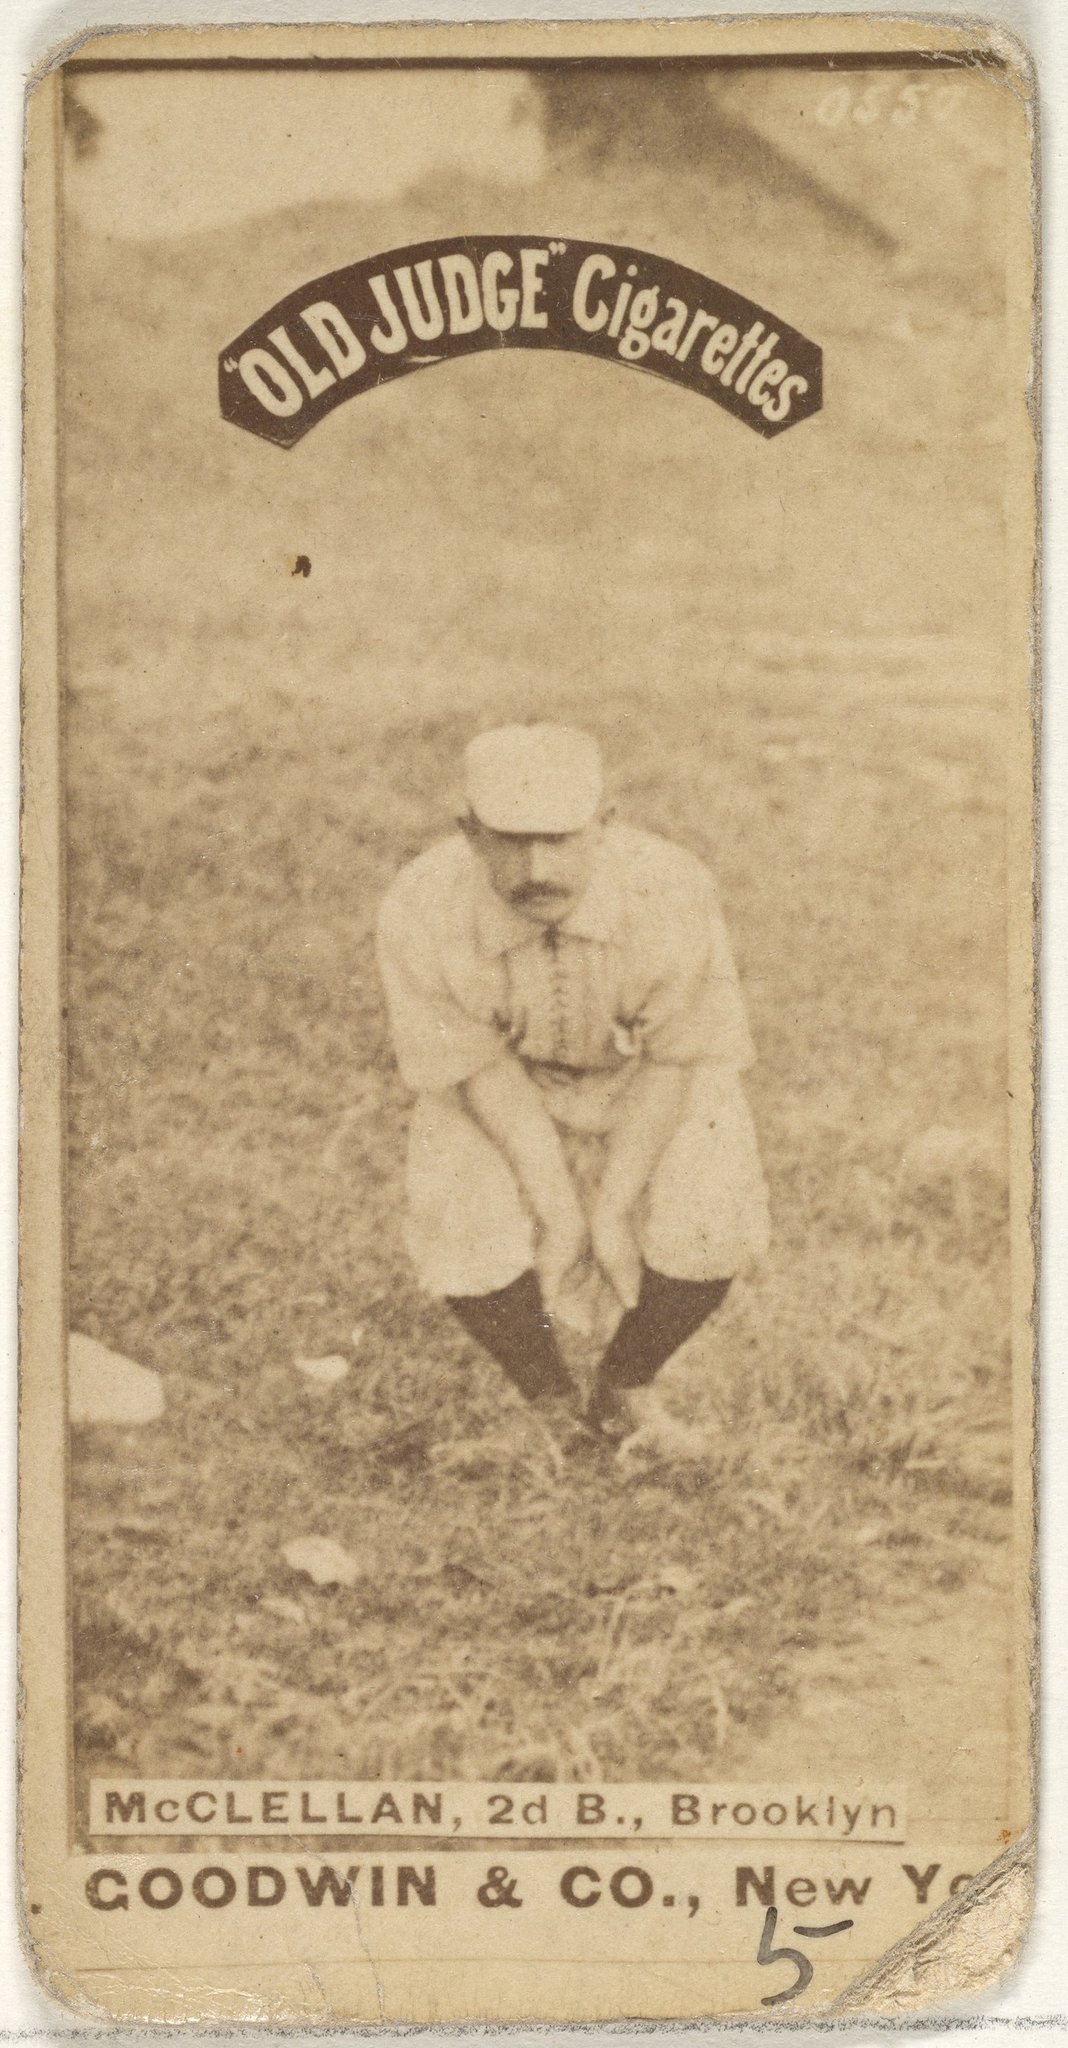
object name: baseball card, photograph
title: McClellan, 2nd Base, Brooklyn, from the Old Judge series (N172) for Old Judge Cigarettes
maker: goodwin & company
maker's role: publisher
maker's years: 1850-1950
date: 1887-1890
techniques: albumen silver print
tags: men,portraits,baseball,athletes